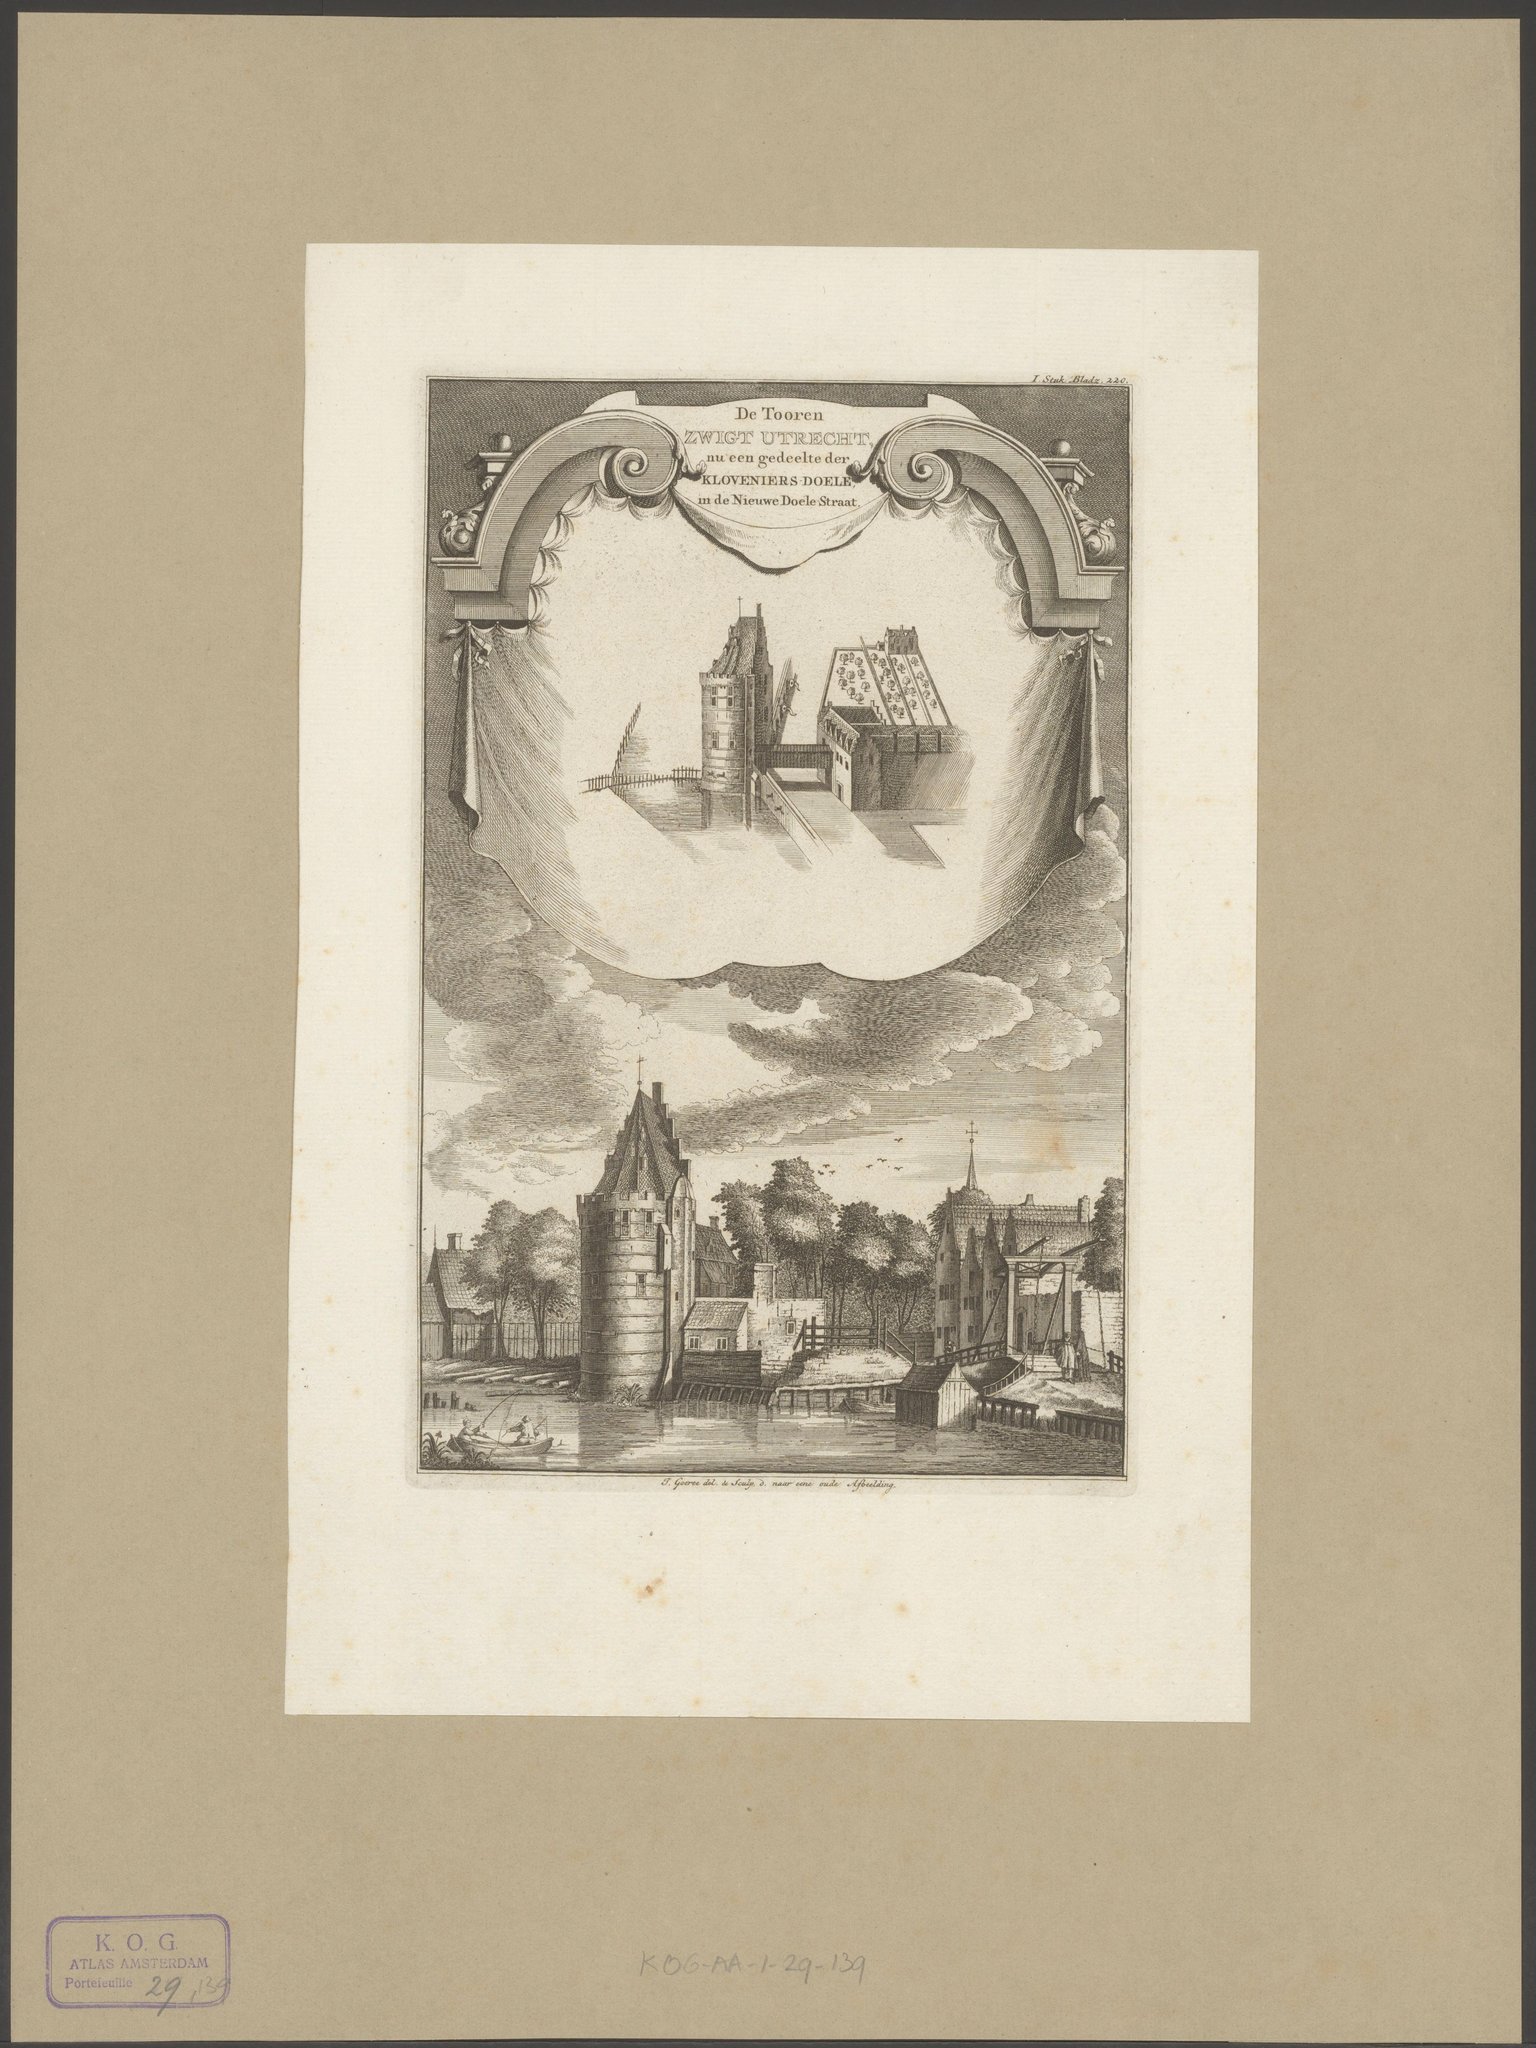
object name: print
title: Twee gezichten op de toren Swych Utrecht te Amsterdam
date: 1760-1782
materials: paper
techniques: engraving, etching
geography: harlingen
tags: towers ~ fortified city, rowing-boat, canoe, etc., canals, waters (in city) (+ city(-scape) with figures, staffage)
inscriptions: collector's mark: Lugt 1641b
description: Prent mogelijk uit: Wagenaar, Jan. Amsterdam, in zyne opkomst, aanwas, geschiedenissen (...). Amsterdam: Isaak Tirion, 1760, dl. 1, p. 220. Of uit: Verzameling der fraaiste gezigten van Amsterdam in negen en zeventig afbeeldingen. Amsterdam en Harlingen: Petrus Conradi en Volkert van der Plaats, 1782.